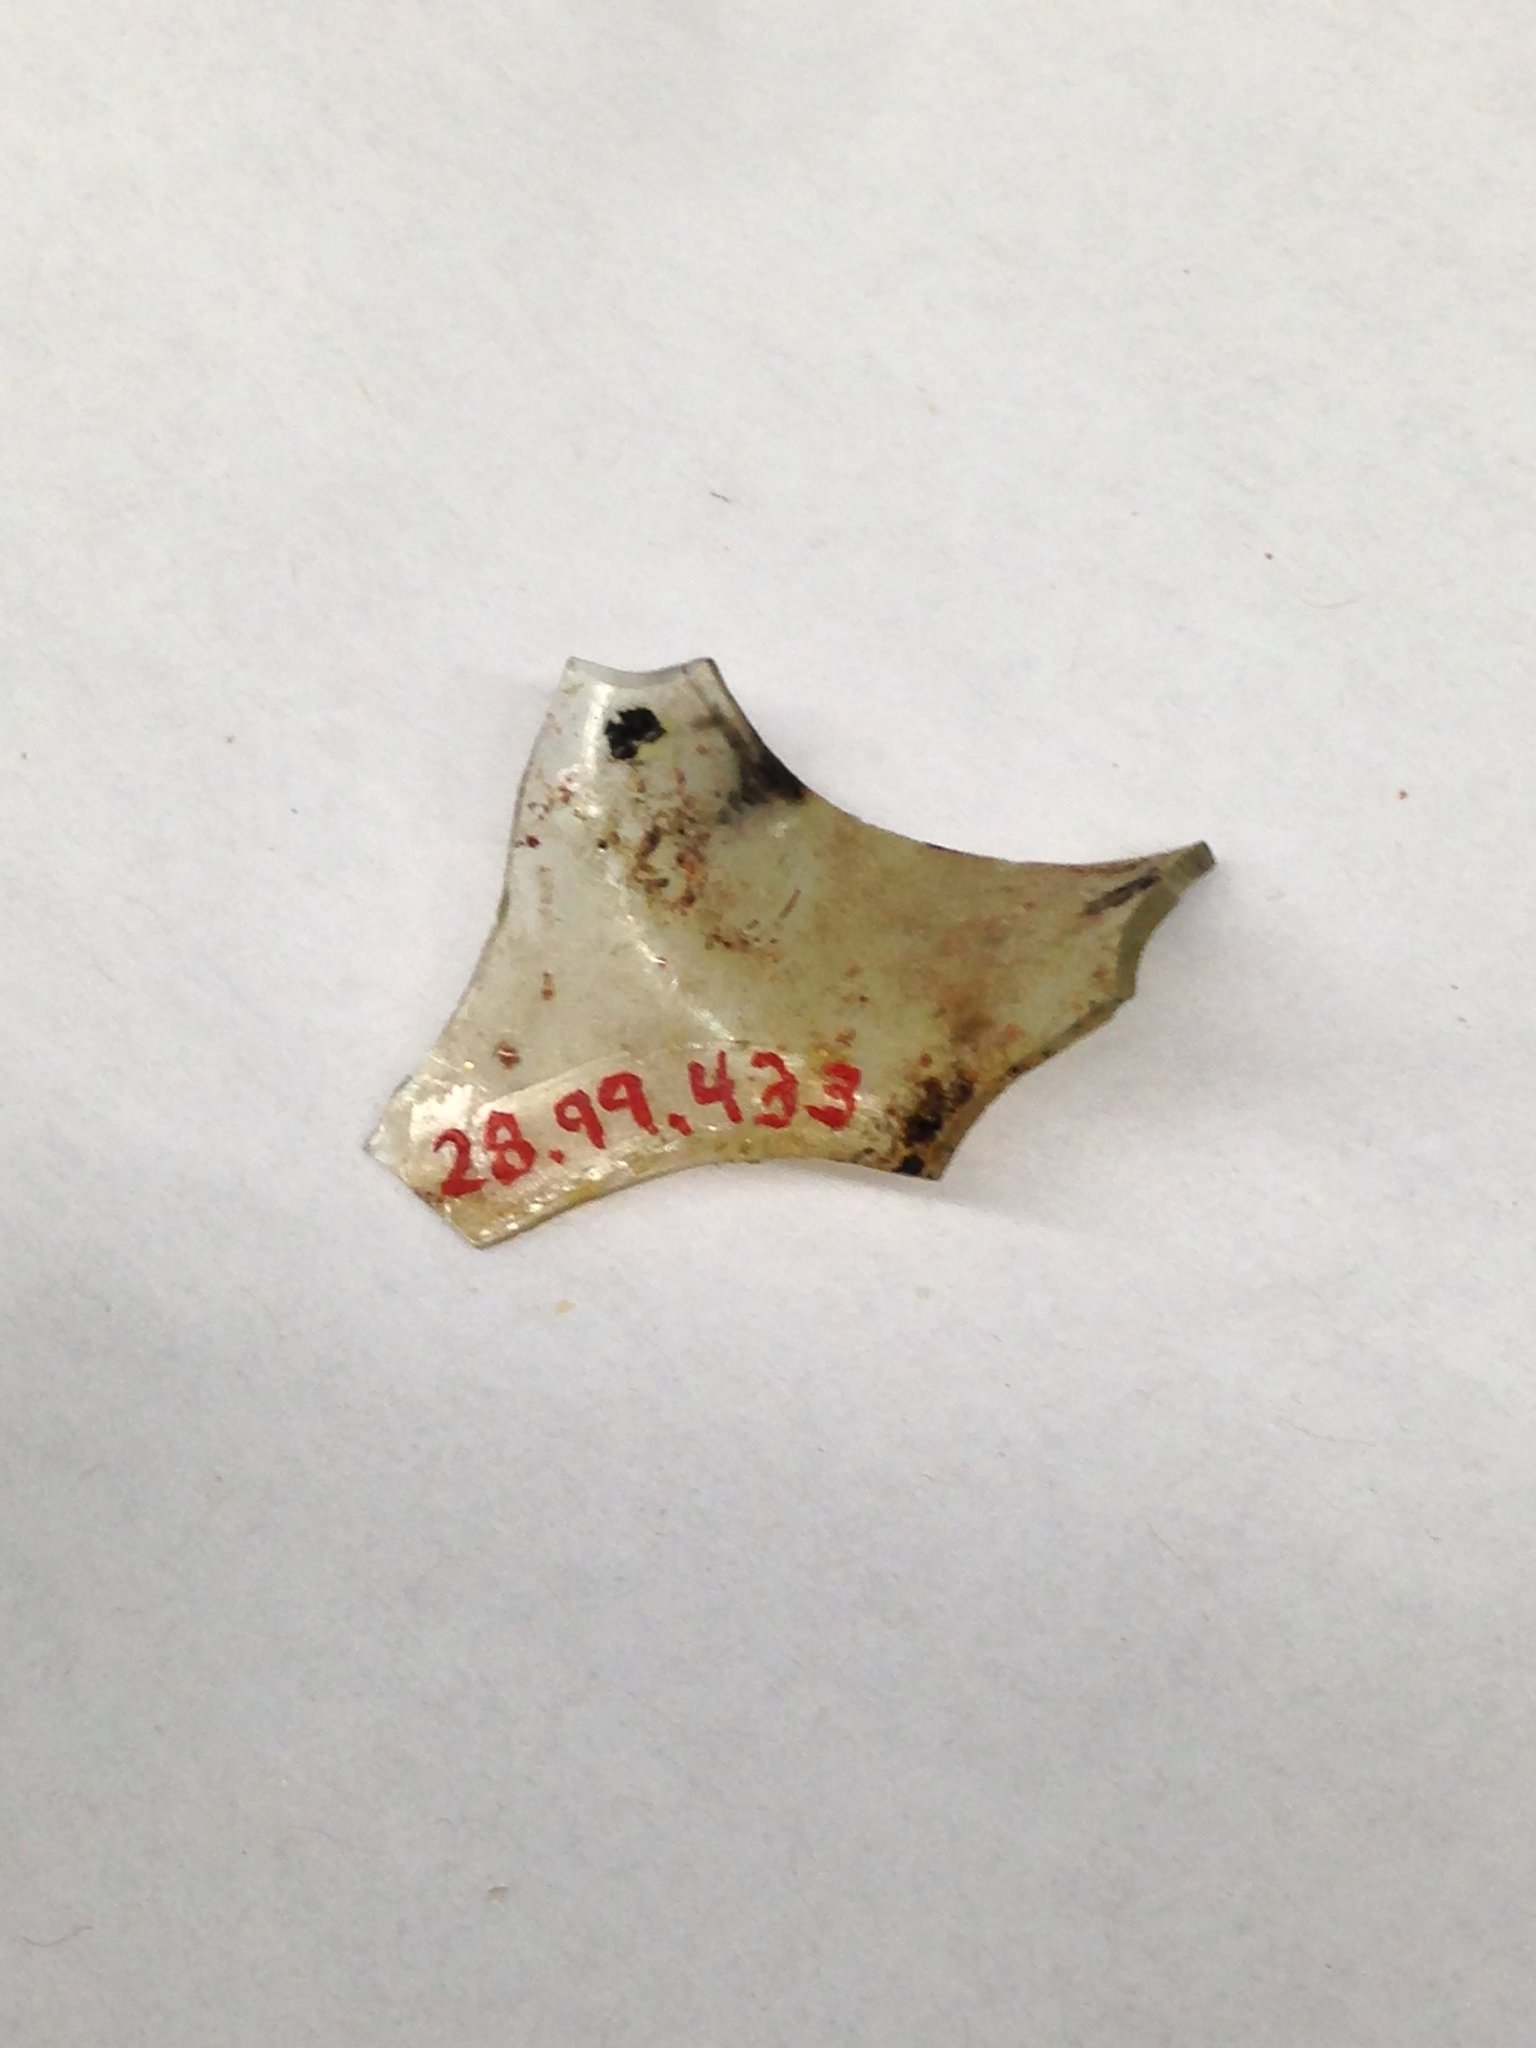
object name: fragment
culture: european or middle eastern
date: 1150-1250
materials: ceramic, glass